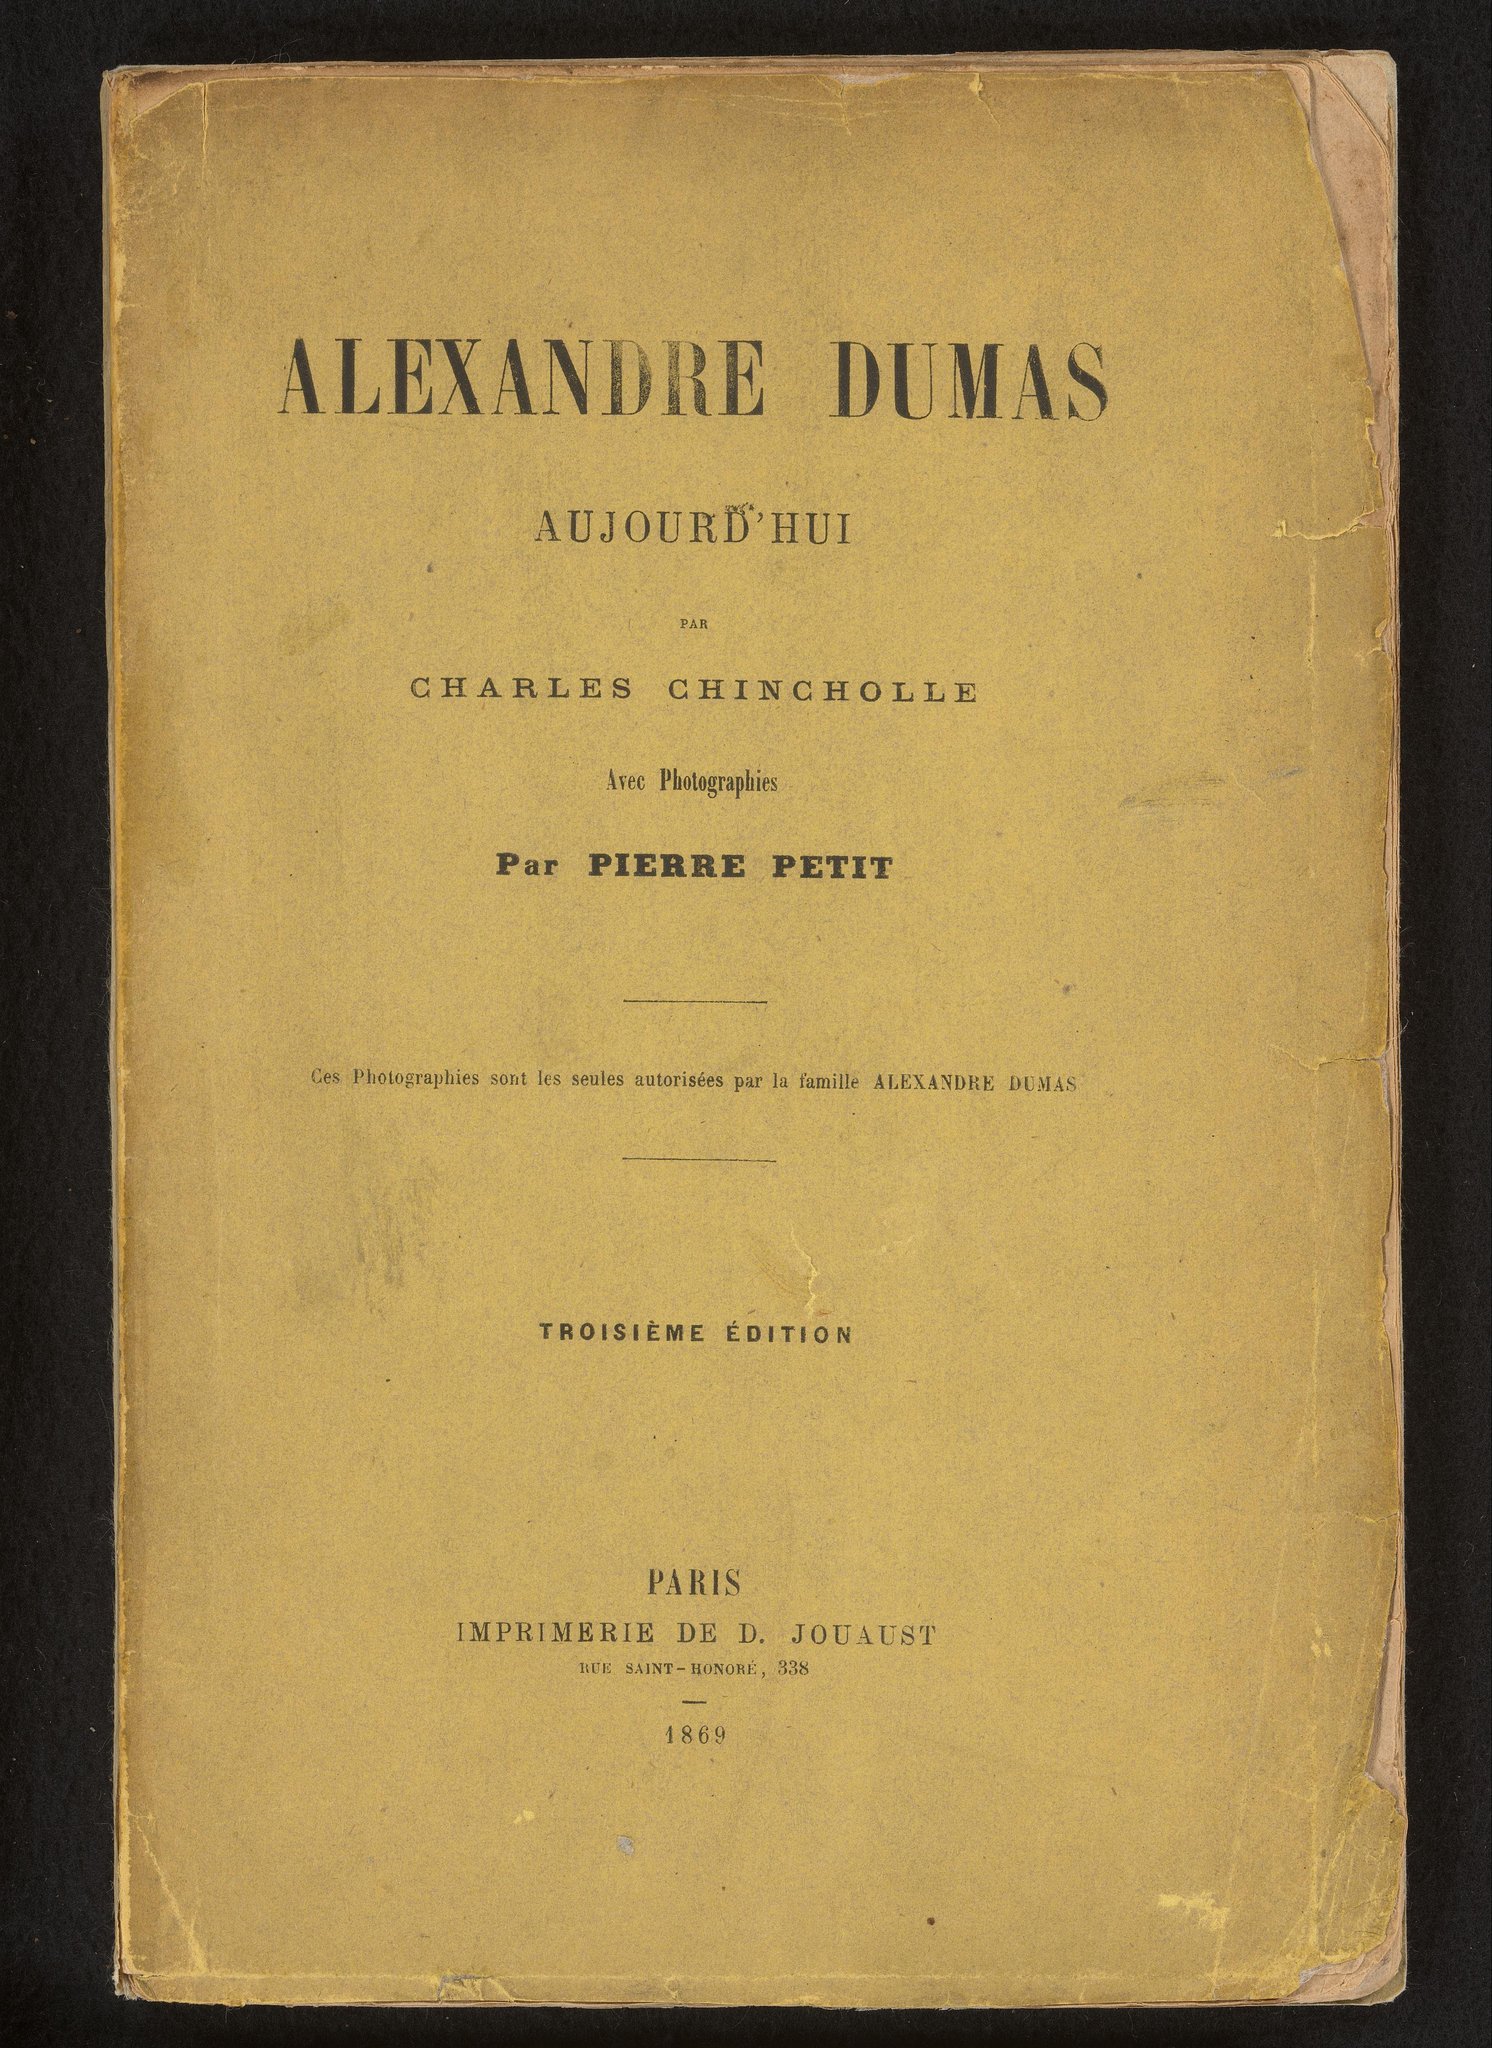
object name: book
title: Alexandre Dumas aujourd'hui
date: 1869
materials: paper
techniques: albumen print, letterpress printing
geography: paris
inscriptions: signature: ‘A. Dumas fils’